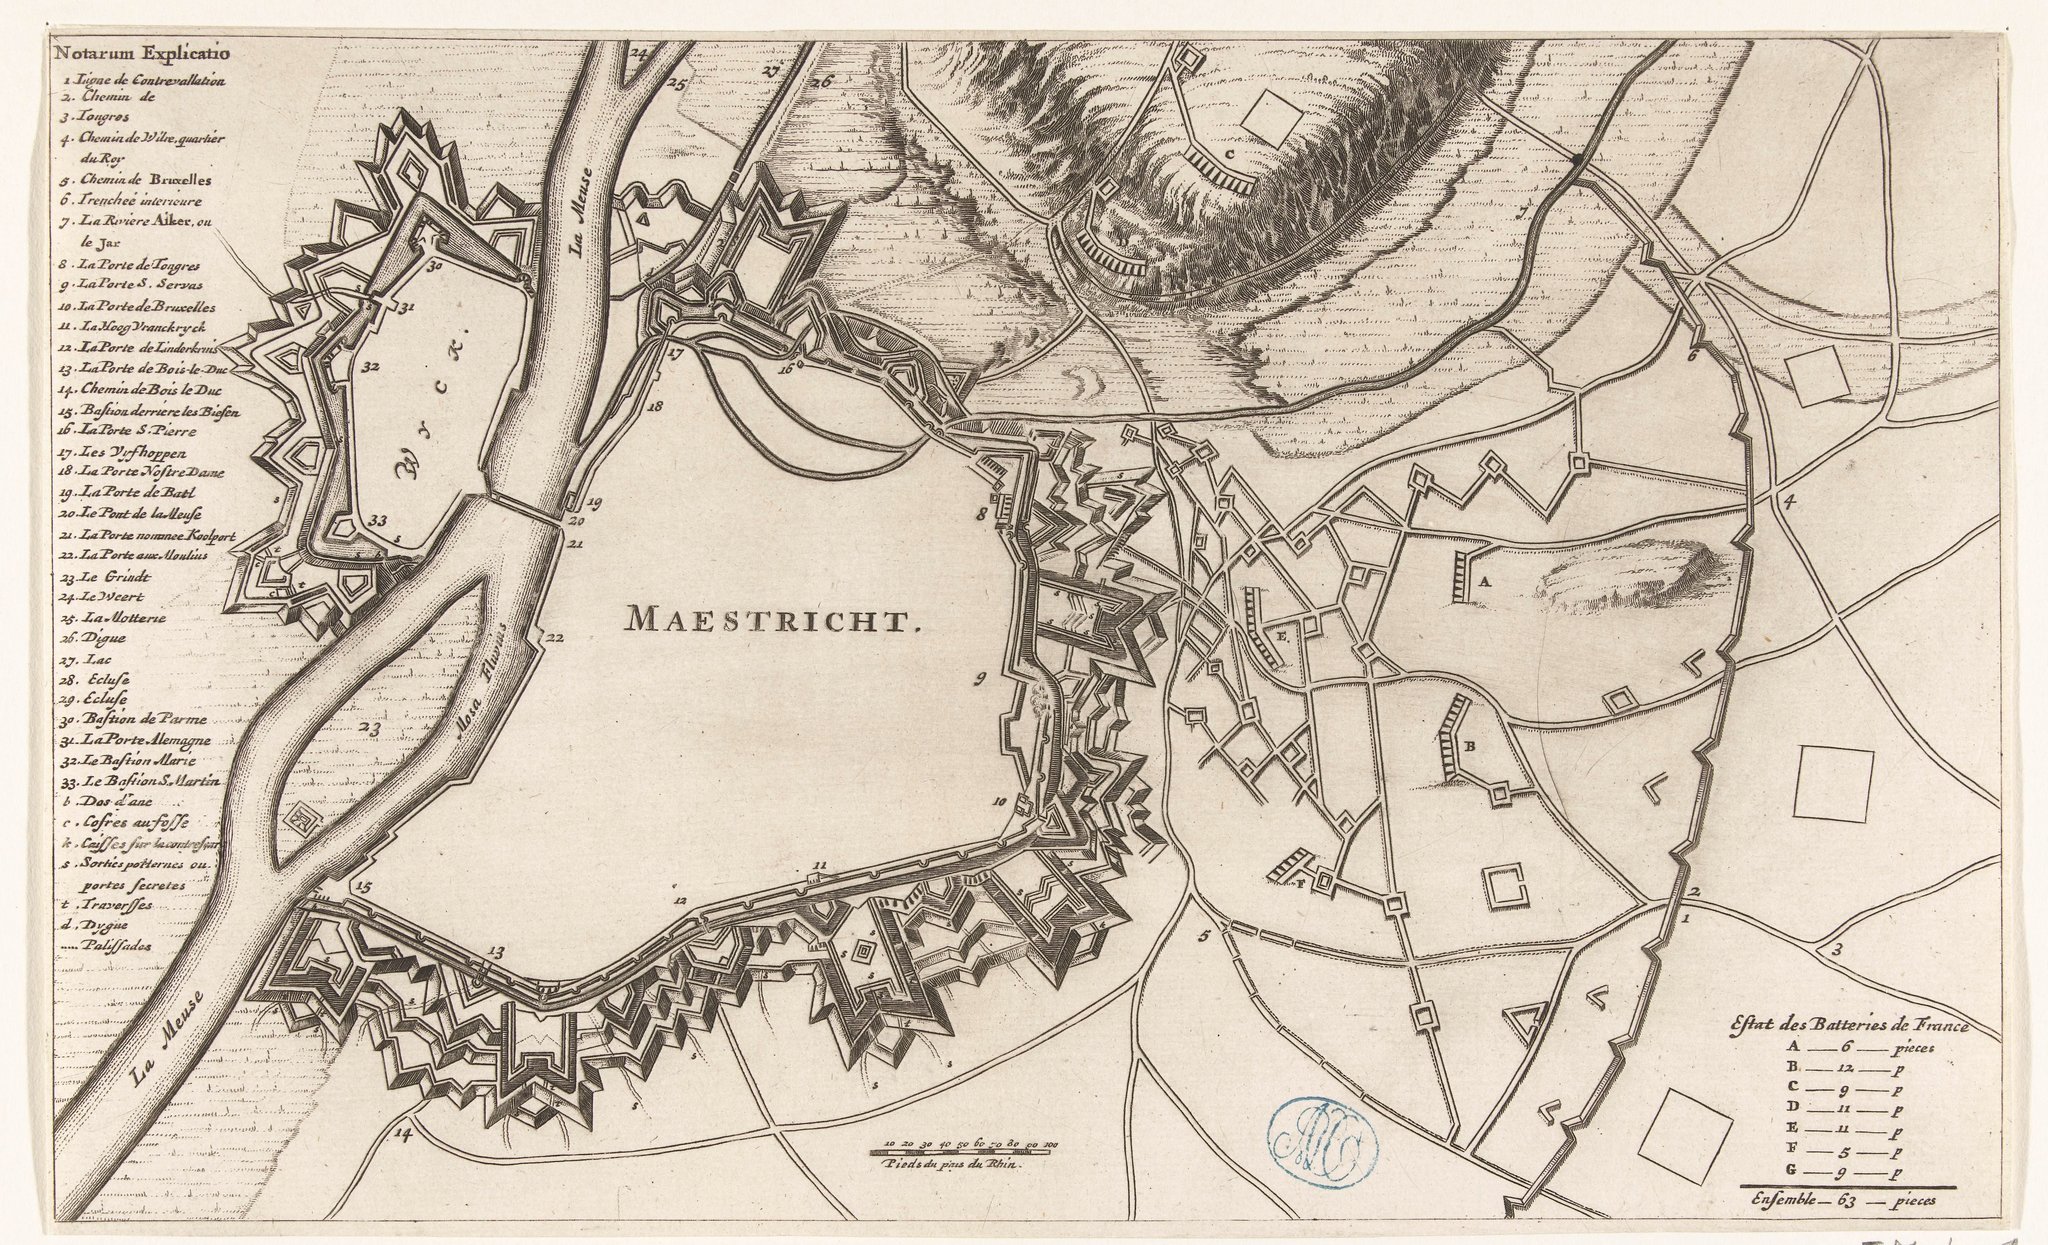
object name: map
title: Plattegrond van Maastricht, 1678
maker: Anonymous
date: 1678-1699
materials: paper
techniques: engraving, etching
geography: france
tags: maps of cities, maastricht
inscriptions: collector's mark: Lugt 195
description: Plattegrond van Maastricht, met de vestingwerken zoals deze waren bij de teruggave van de stad door de Fransen bij de vrede van Nijmegen in 1678. Met links de legenda 1-33 in het Frans. Onder, in het midden, een schaalstok: 100 Pieds du pais du Rhin.